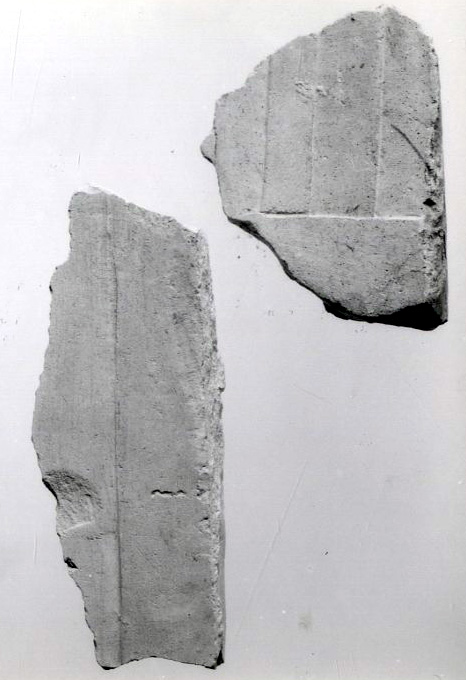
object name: relief fragment, tomb of meketre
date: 1981-1975 BCE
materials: limestone, paint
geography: egypt